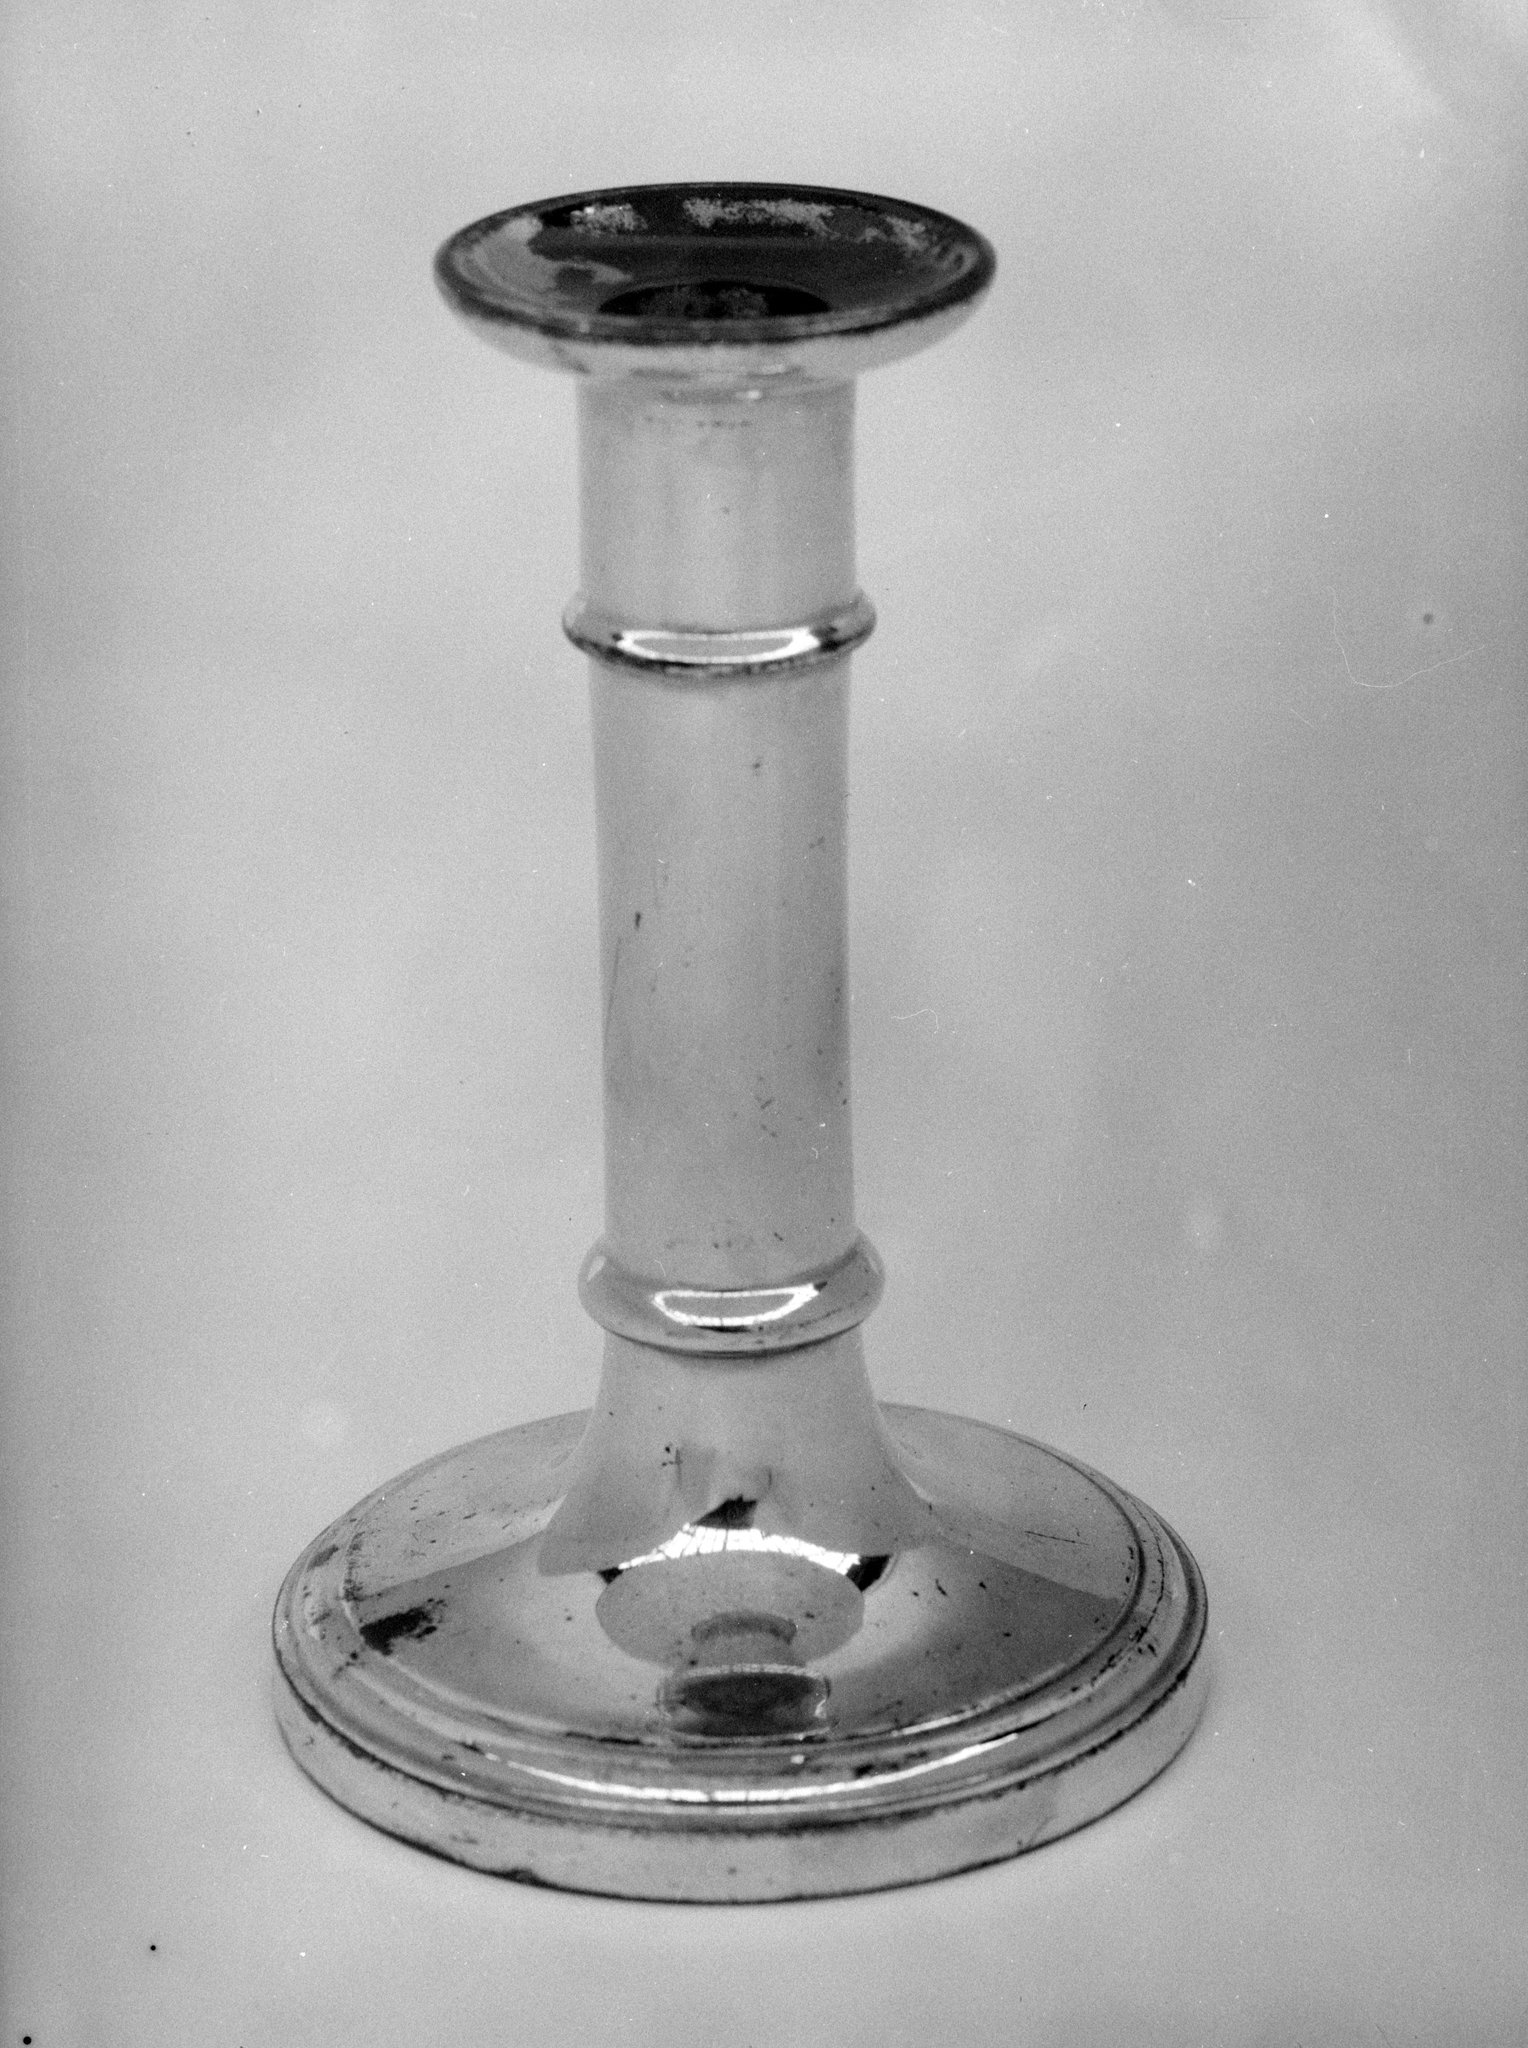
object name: candlestick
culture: british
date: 1800-1830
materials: earthenware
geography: england